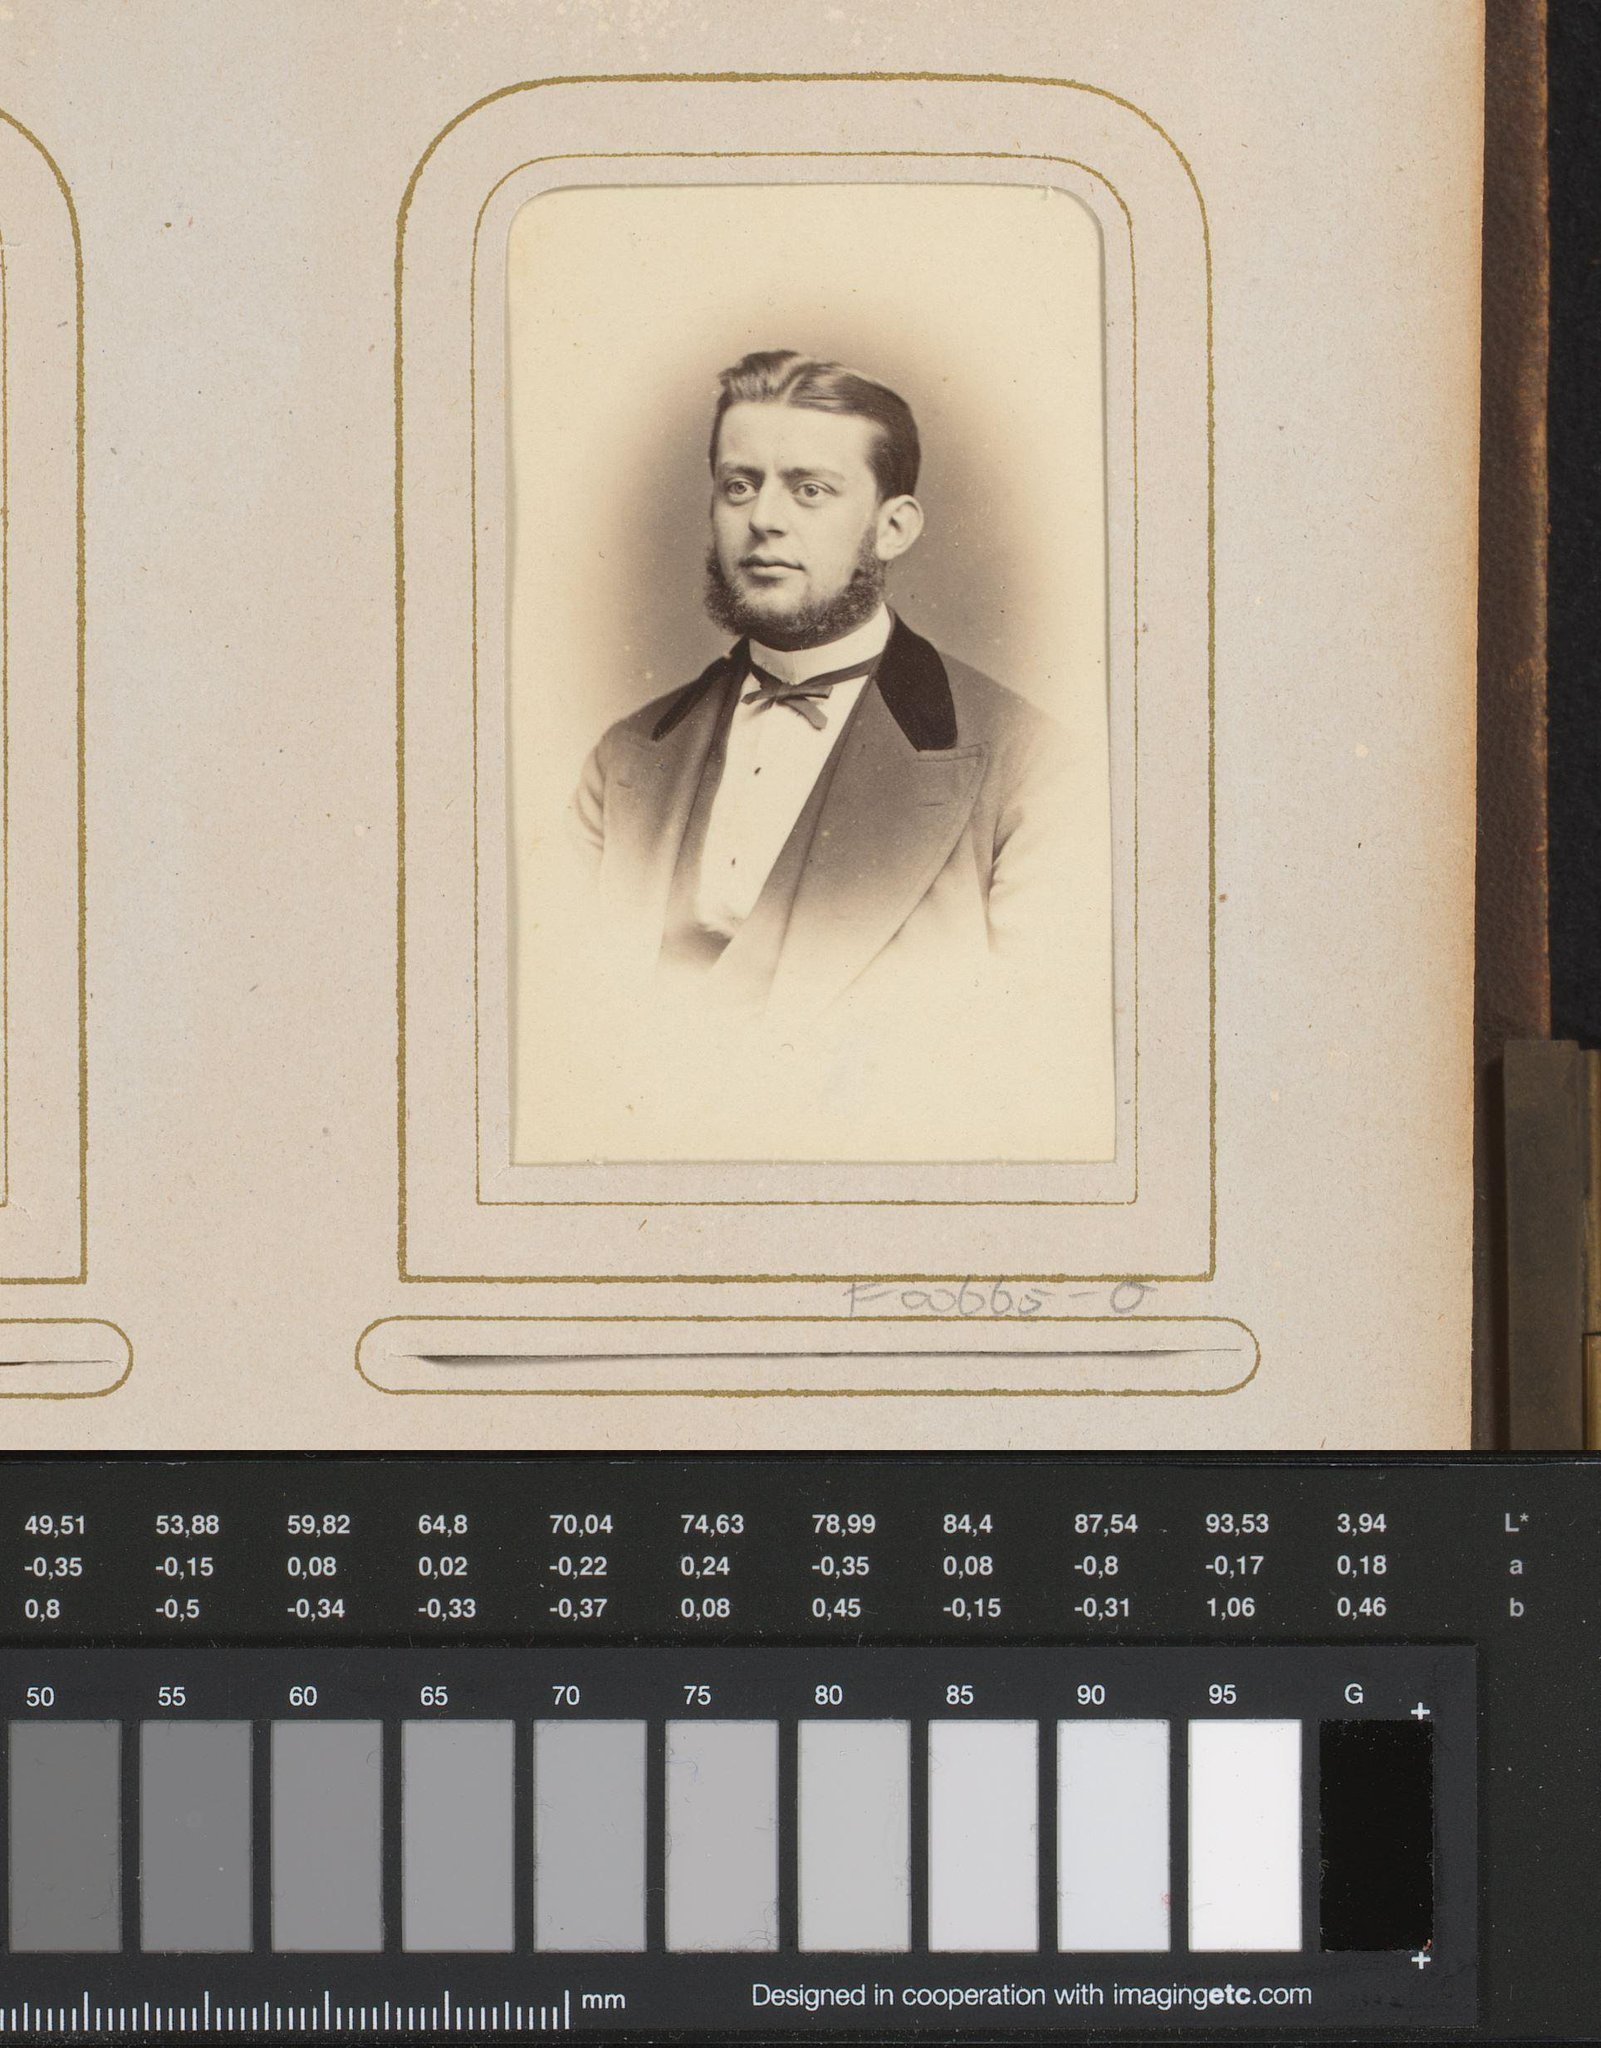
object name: carte de visite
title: Portret van een man met baard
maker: louis robert werner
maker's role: fotograaf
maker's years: 1834-1896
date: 1861-1866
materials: cardboard, photographic support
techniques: albumen print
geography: amsterdam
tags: historical persons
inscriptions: inscription: ‘L.R. Werner/ voorheen P. Carstensen/ Nieuwendijk H.201/ Amsterdam’